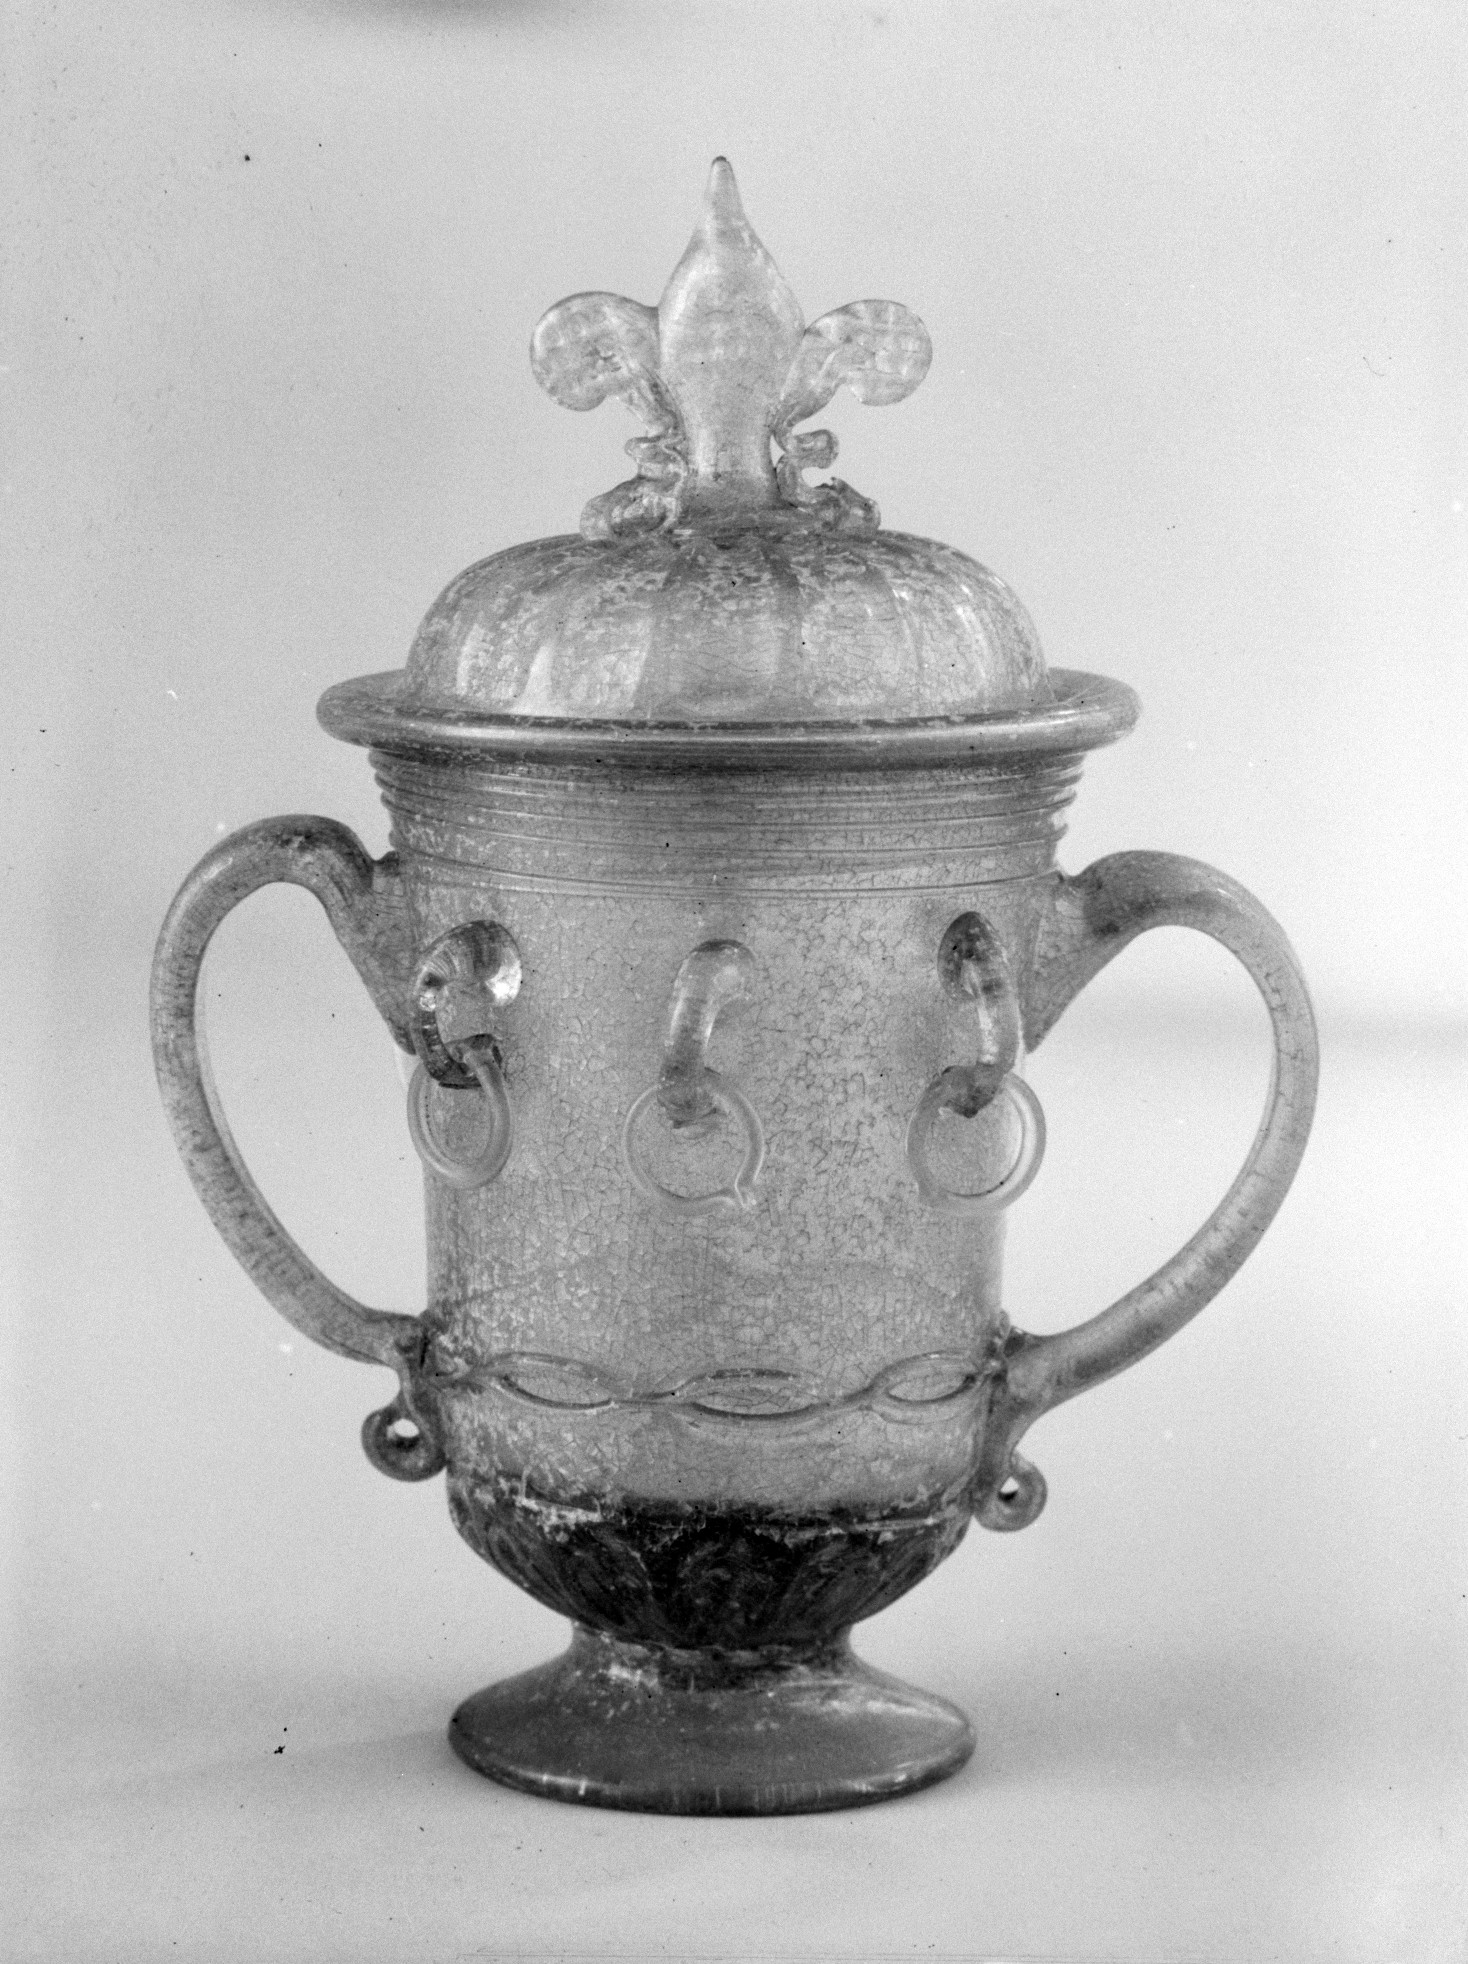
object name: standing cup with cover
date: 1601-1800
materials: glass